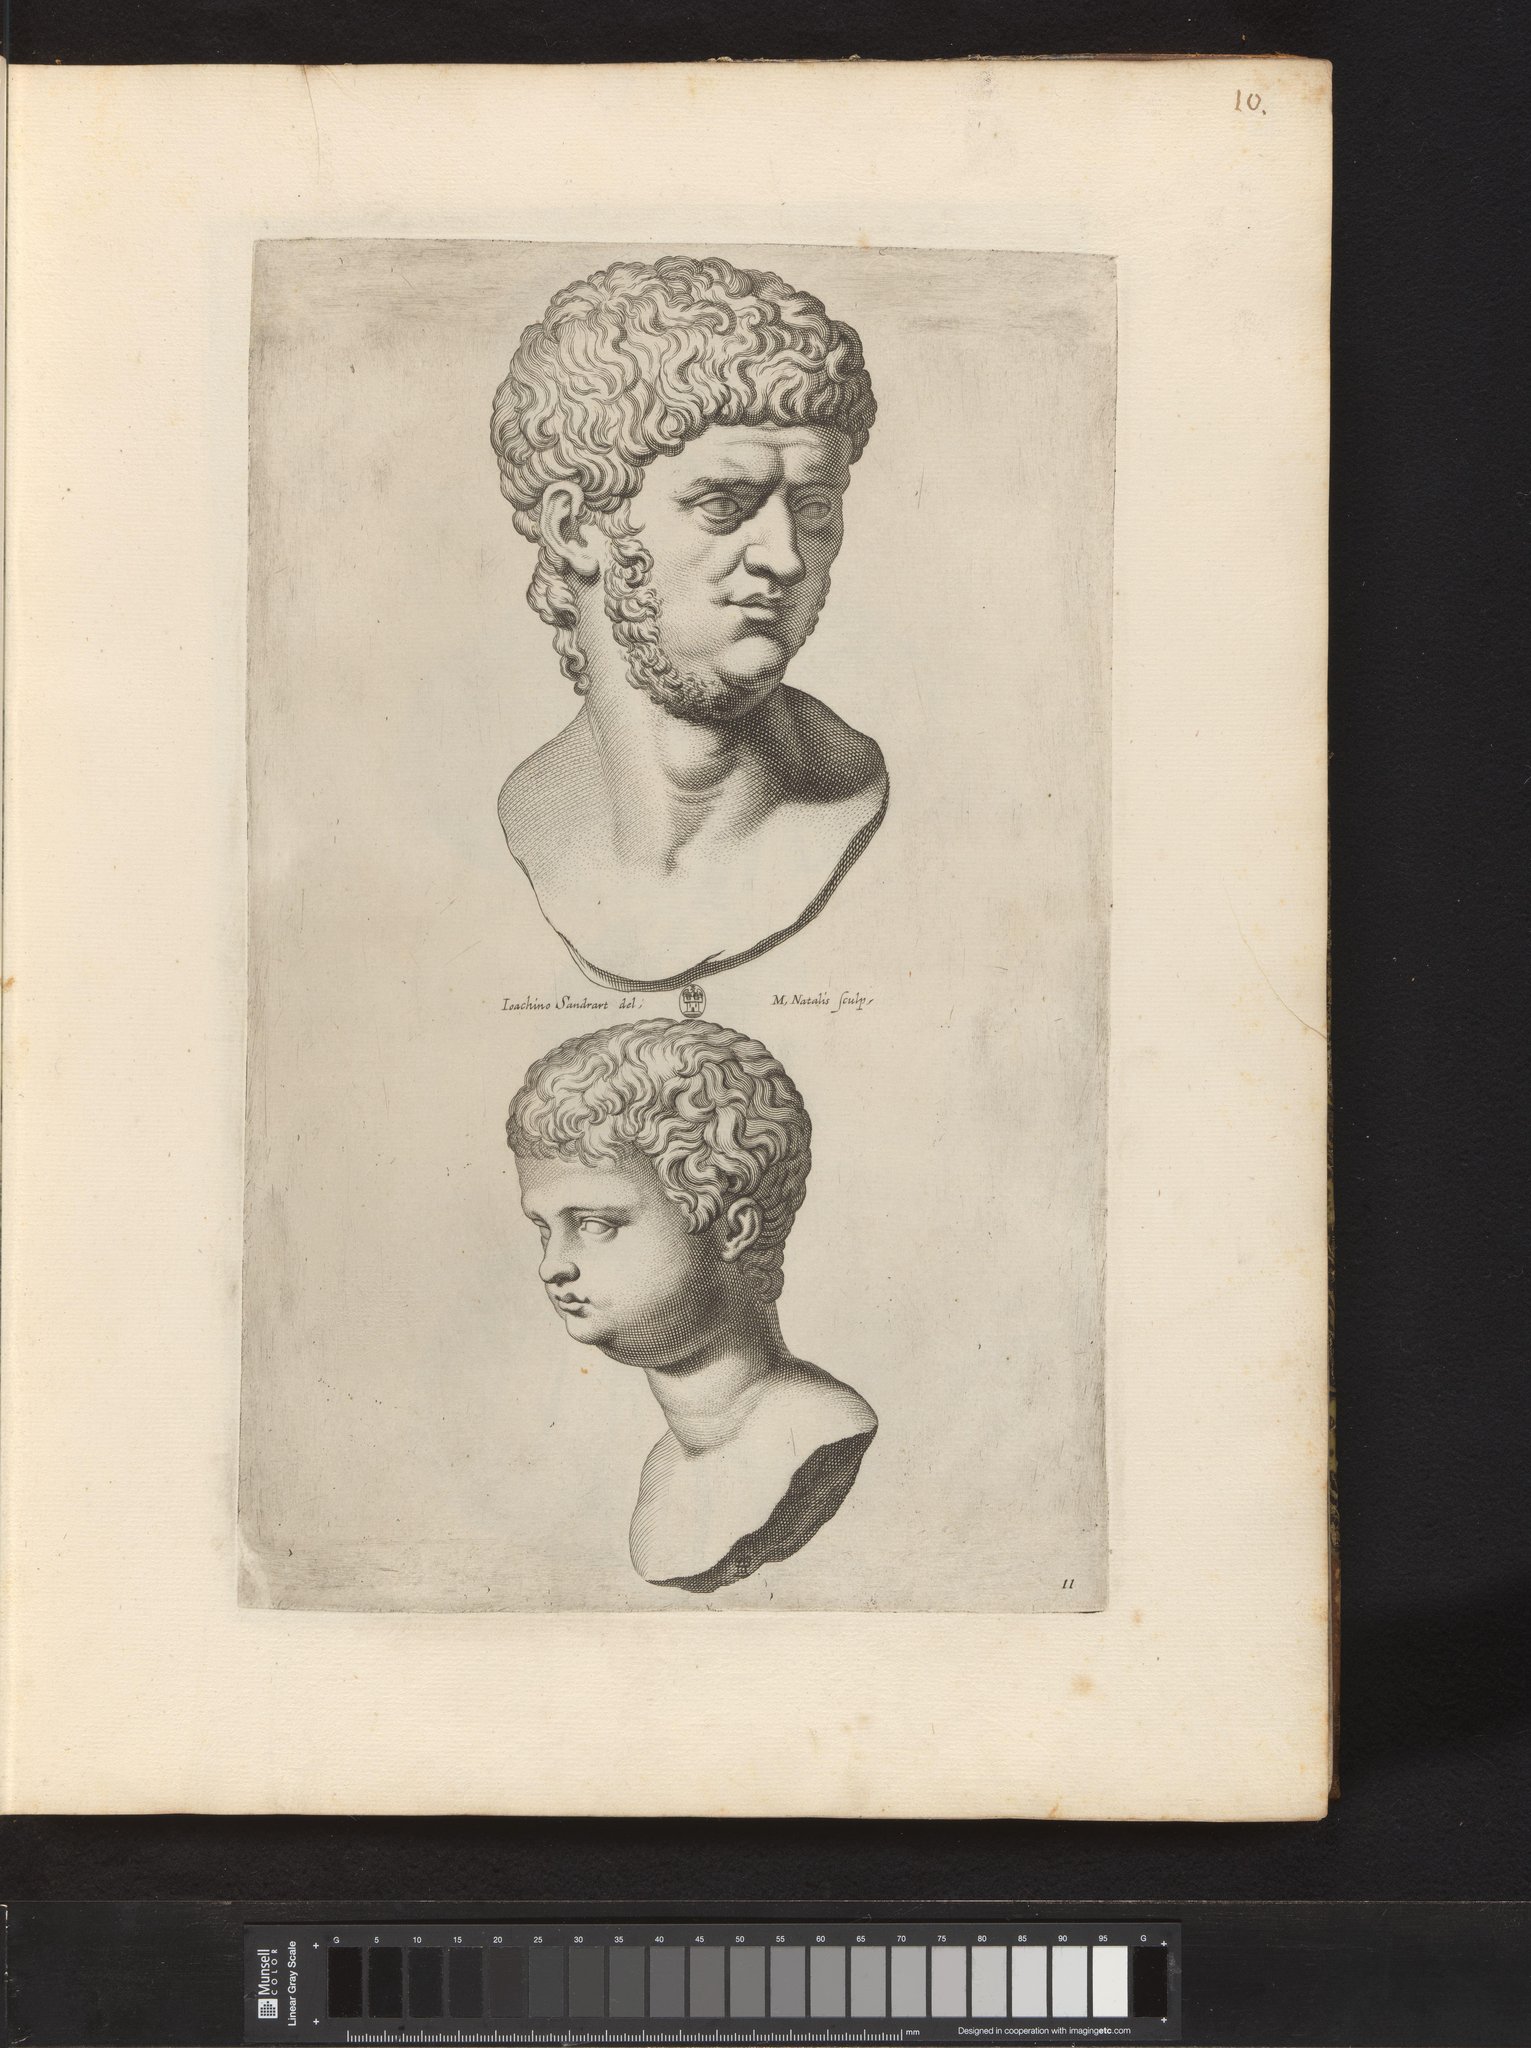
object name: album leaf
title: Portretbustes van Caracalla en Geta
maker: michel natalis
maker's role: print maker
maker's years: 1610-1668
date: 1636-1647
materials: paper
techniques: engraving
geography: rome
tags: male persons from classical history (+ head, bust, etc.), piece of sculpture, reproduction of a piece of sculpture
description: Portretbustes van een Caracalla en Geta. Op de bustes het wapenschild van Vincenzo Giustiniani. Prent maakt deel uit van een album met een serie prenten naar de sculpturen in de verzameling in de Galleria Giustiniani te Rome.